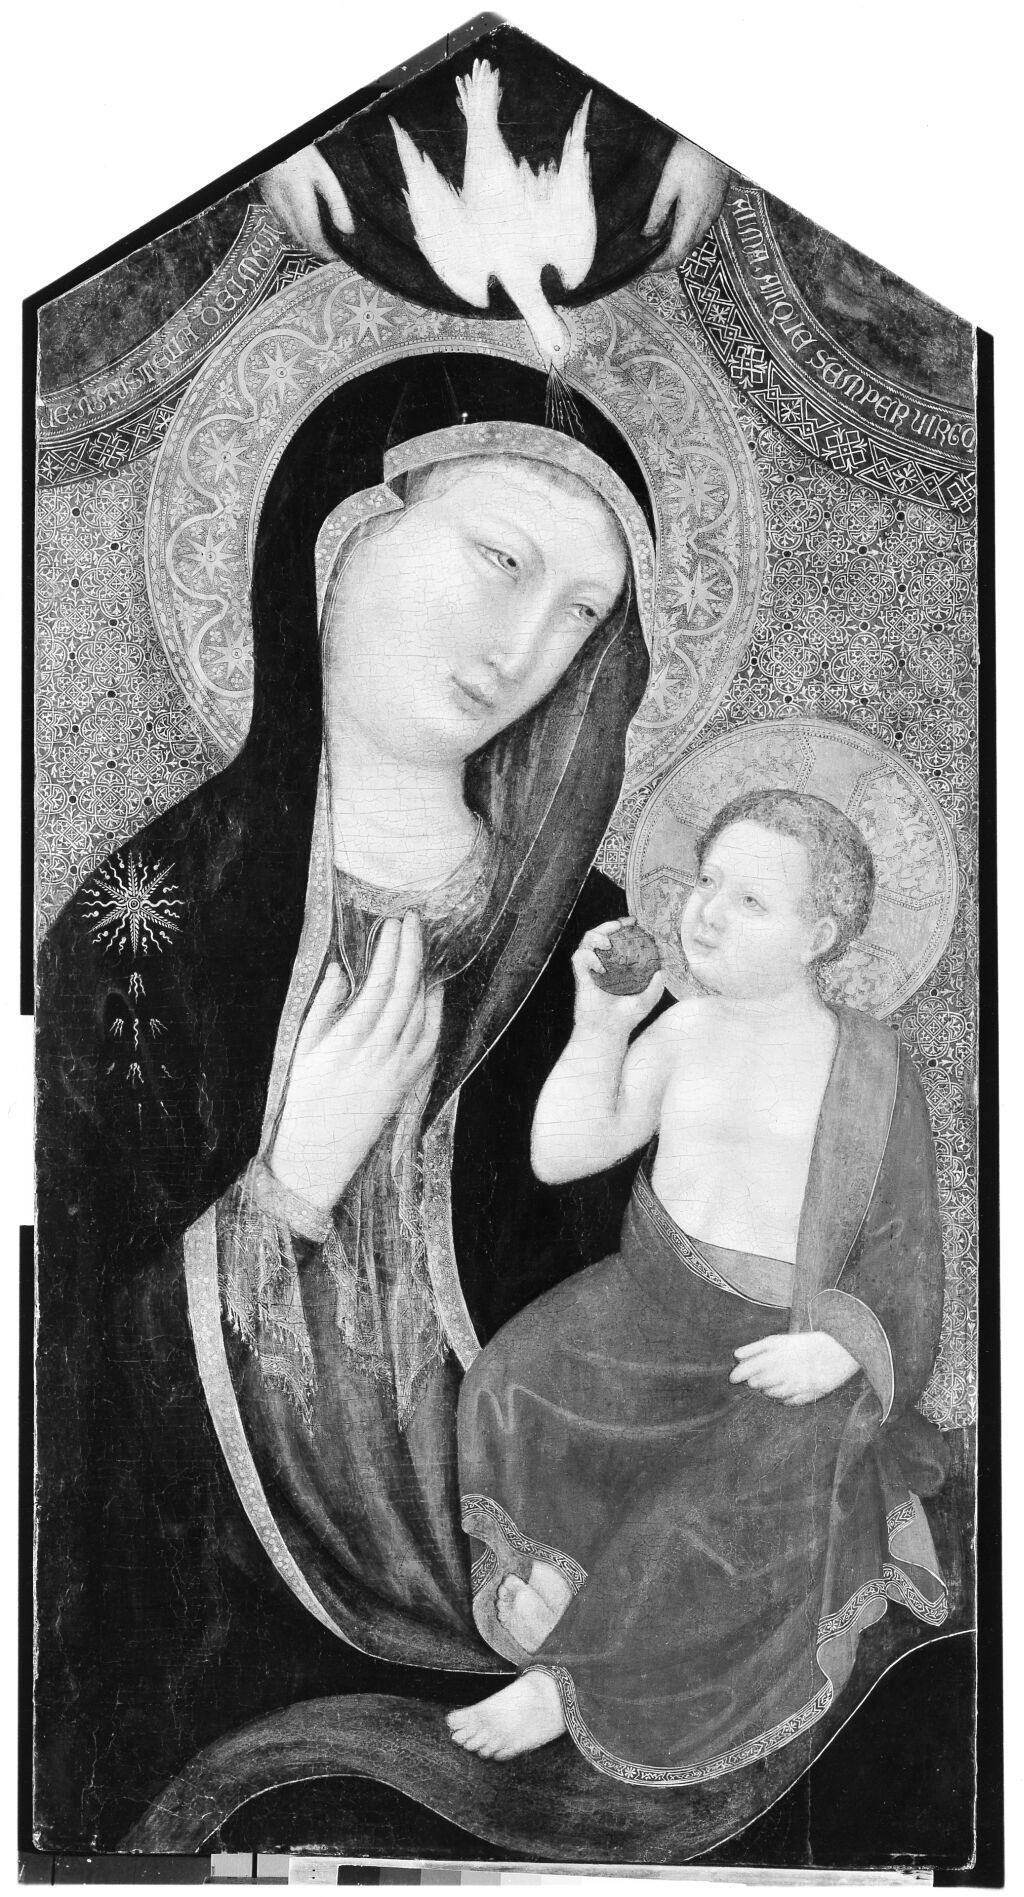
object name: painting fragment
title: Madonna and Child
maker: lippo di benivieni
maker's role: artist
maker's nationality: italian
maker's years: 1296-1327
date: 1296-1327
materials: gold leaf, paint, wood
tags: doves,madonna and child